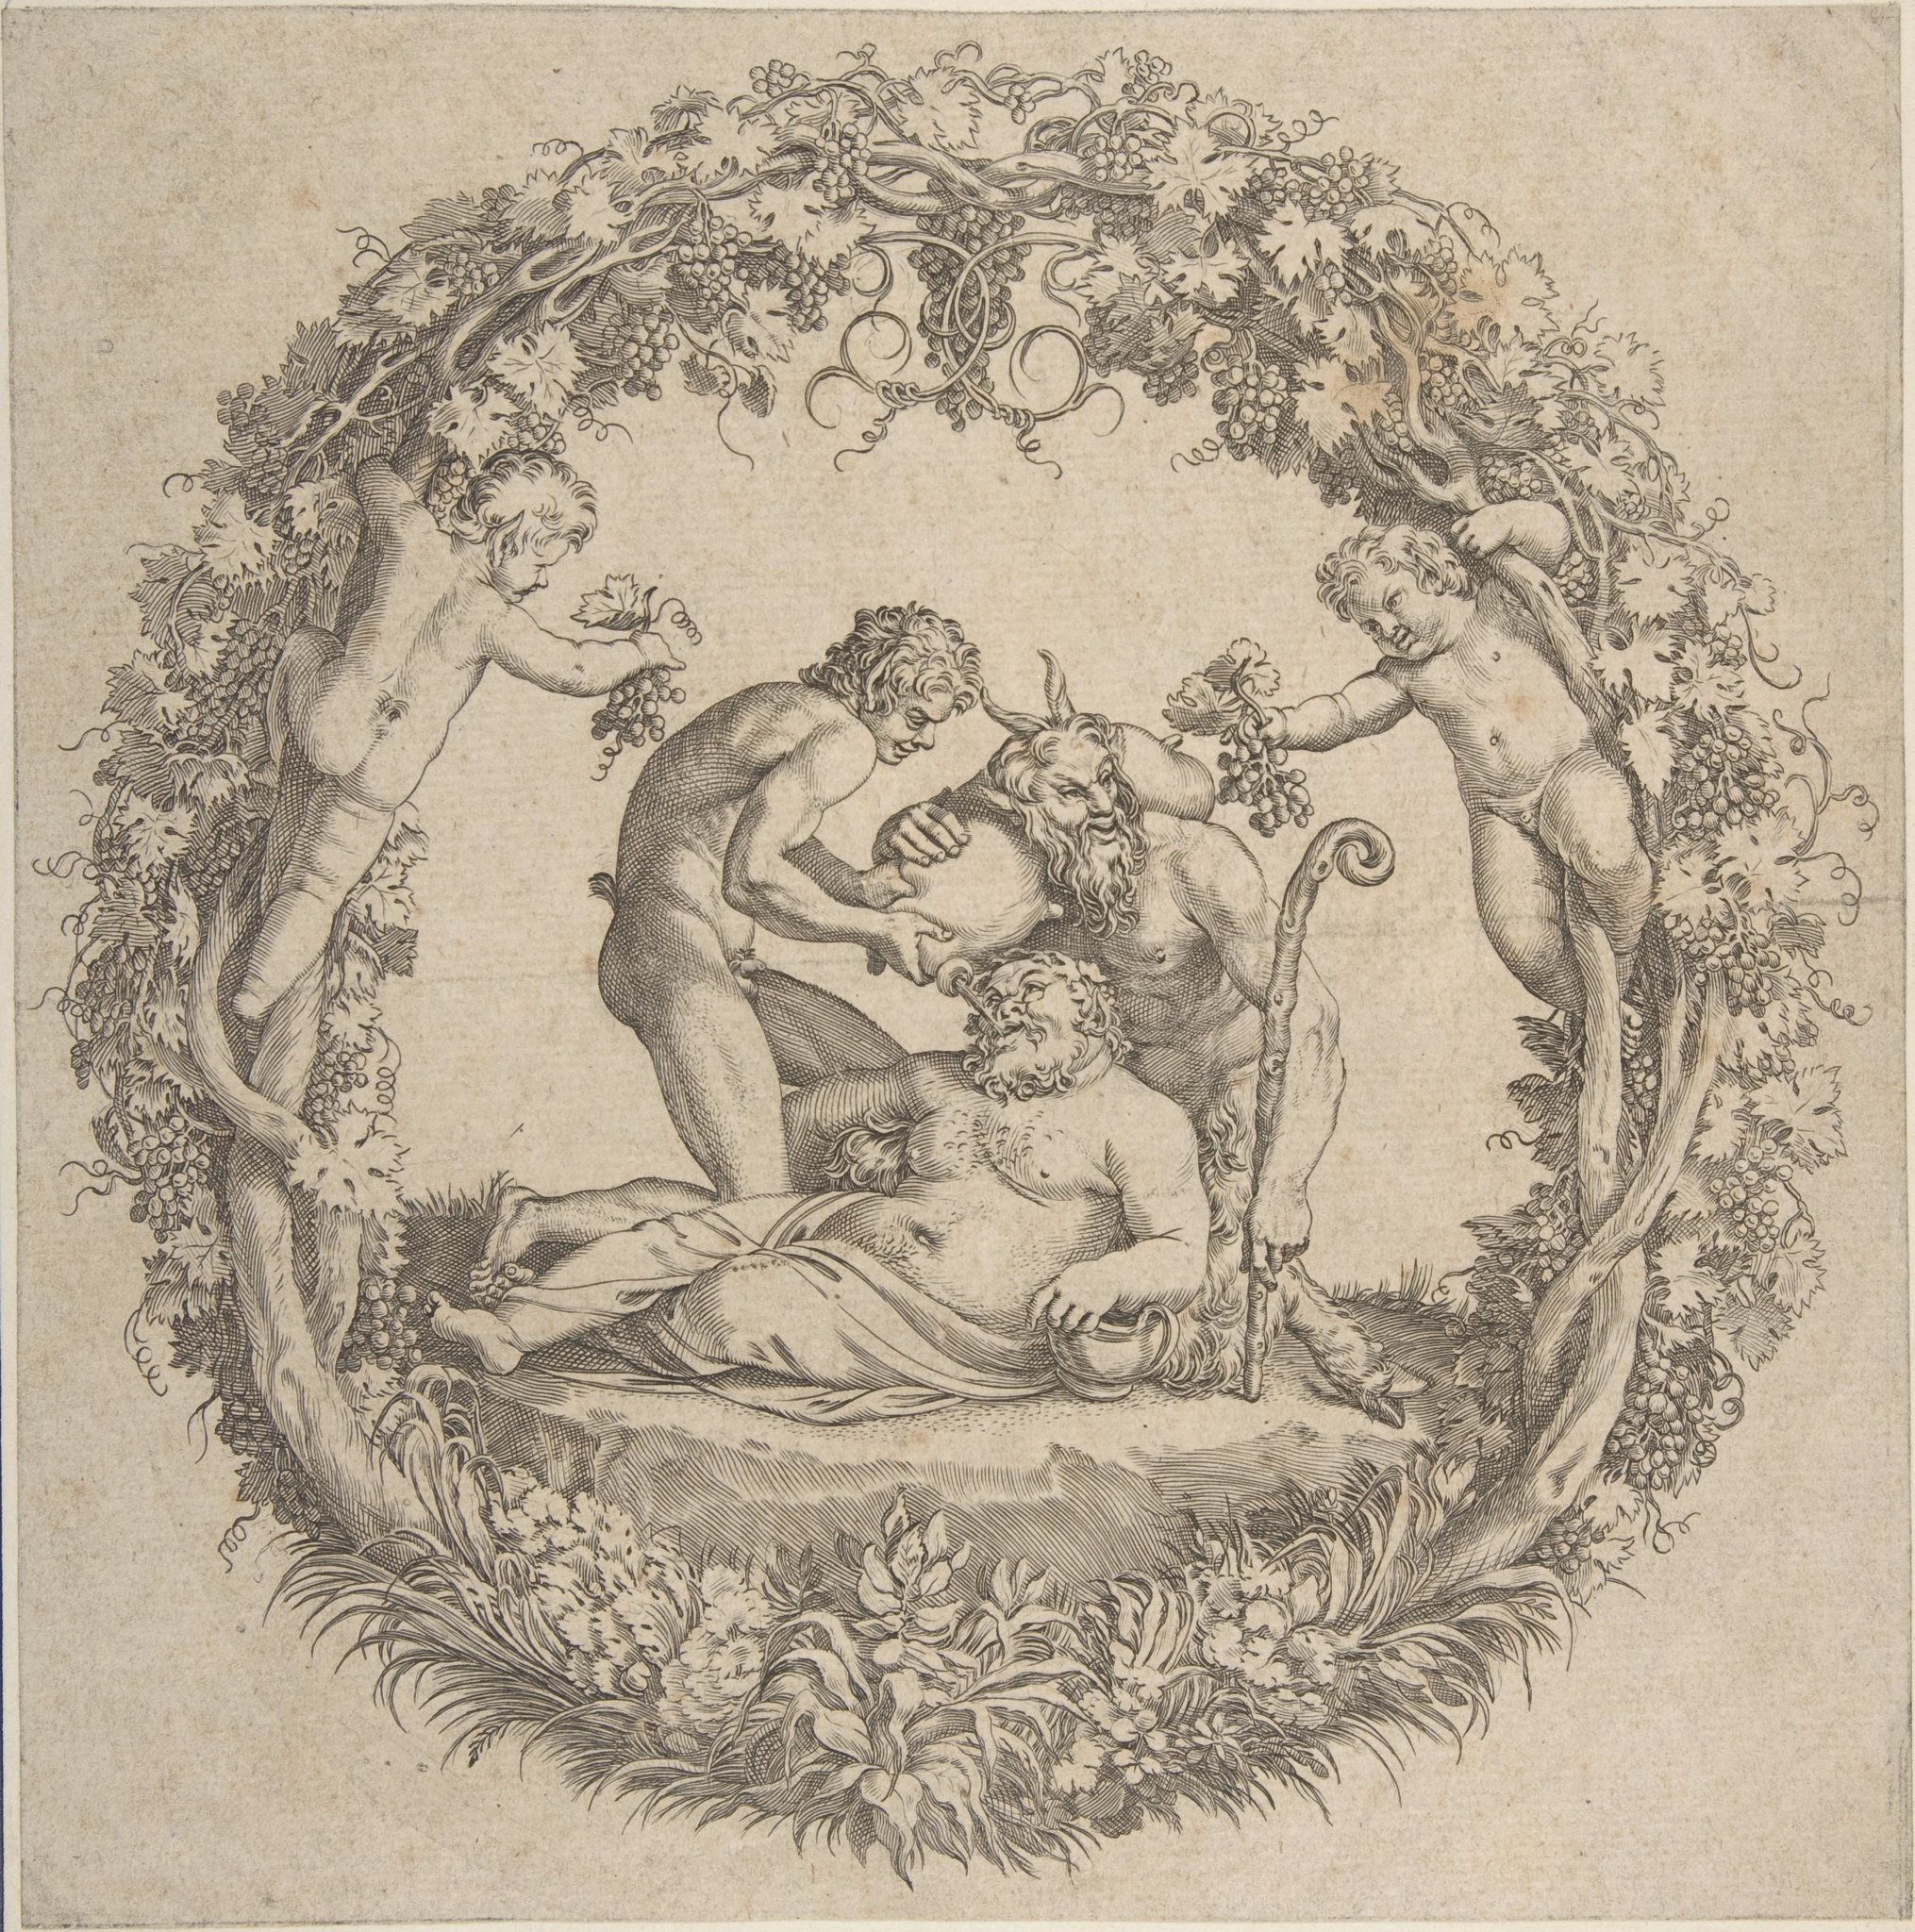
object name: print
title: The Drunken Silenus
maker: annibale carracci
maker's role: artist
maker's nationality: italian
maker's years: 1560-1609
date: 1560-1609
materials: silver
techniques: engraving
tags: male nudes,silenus,drinking